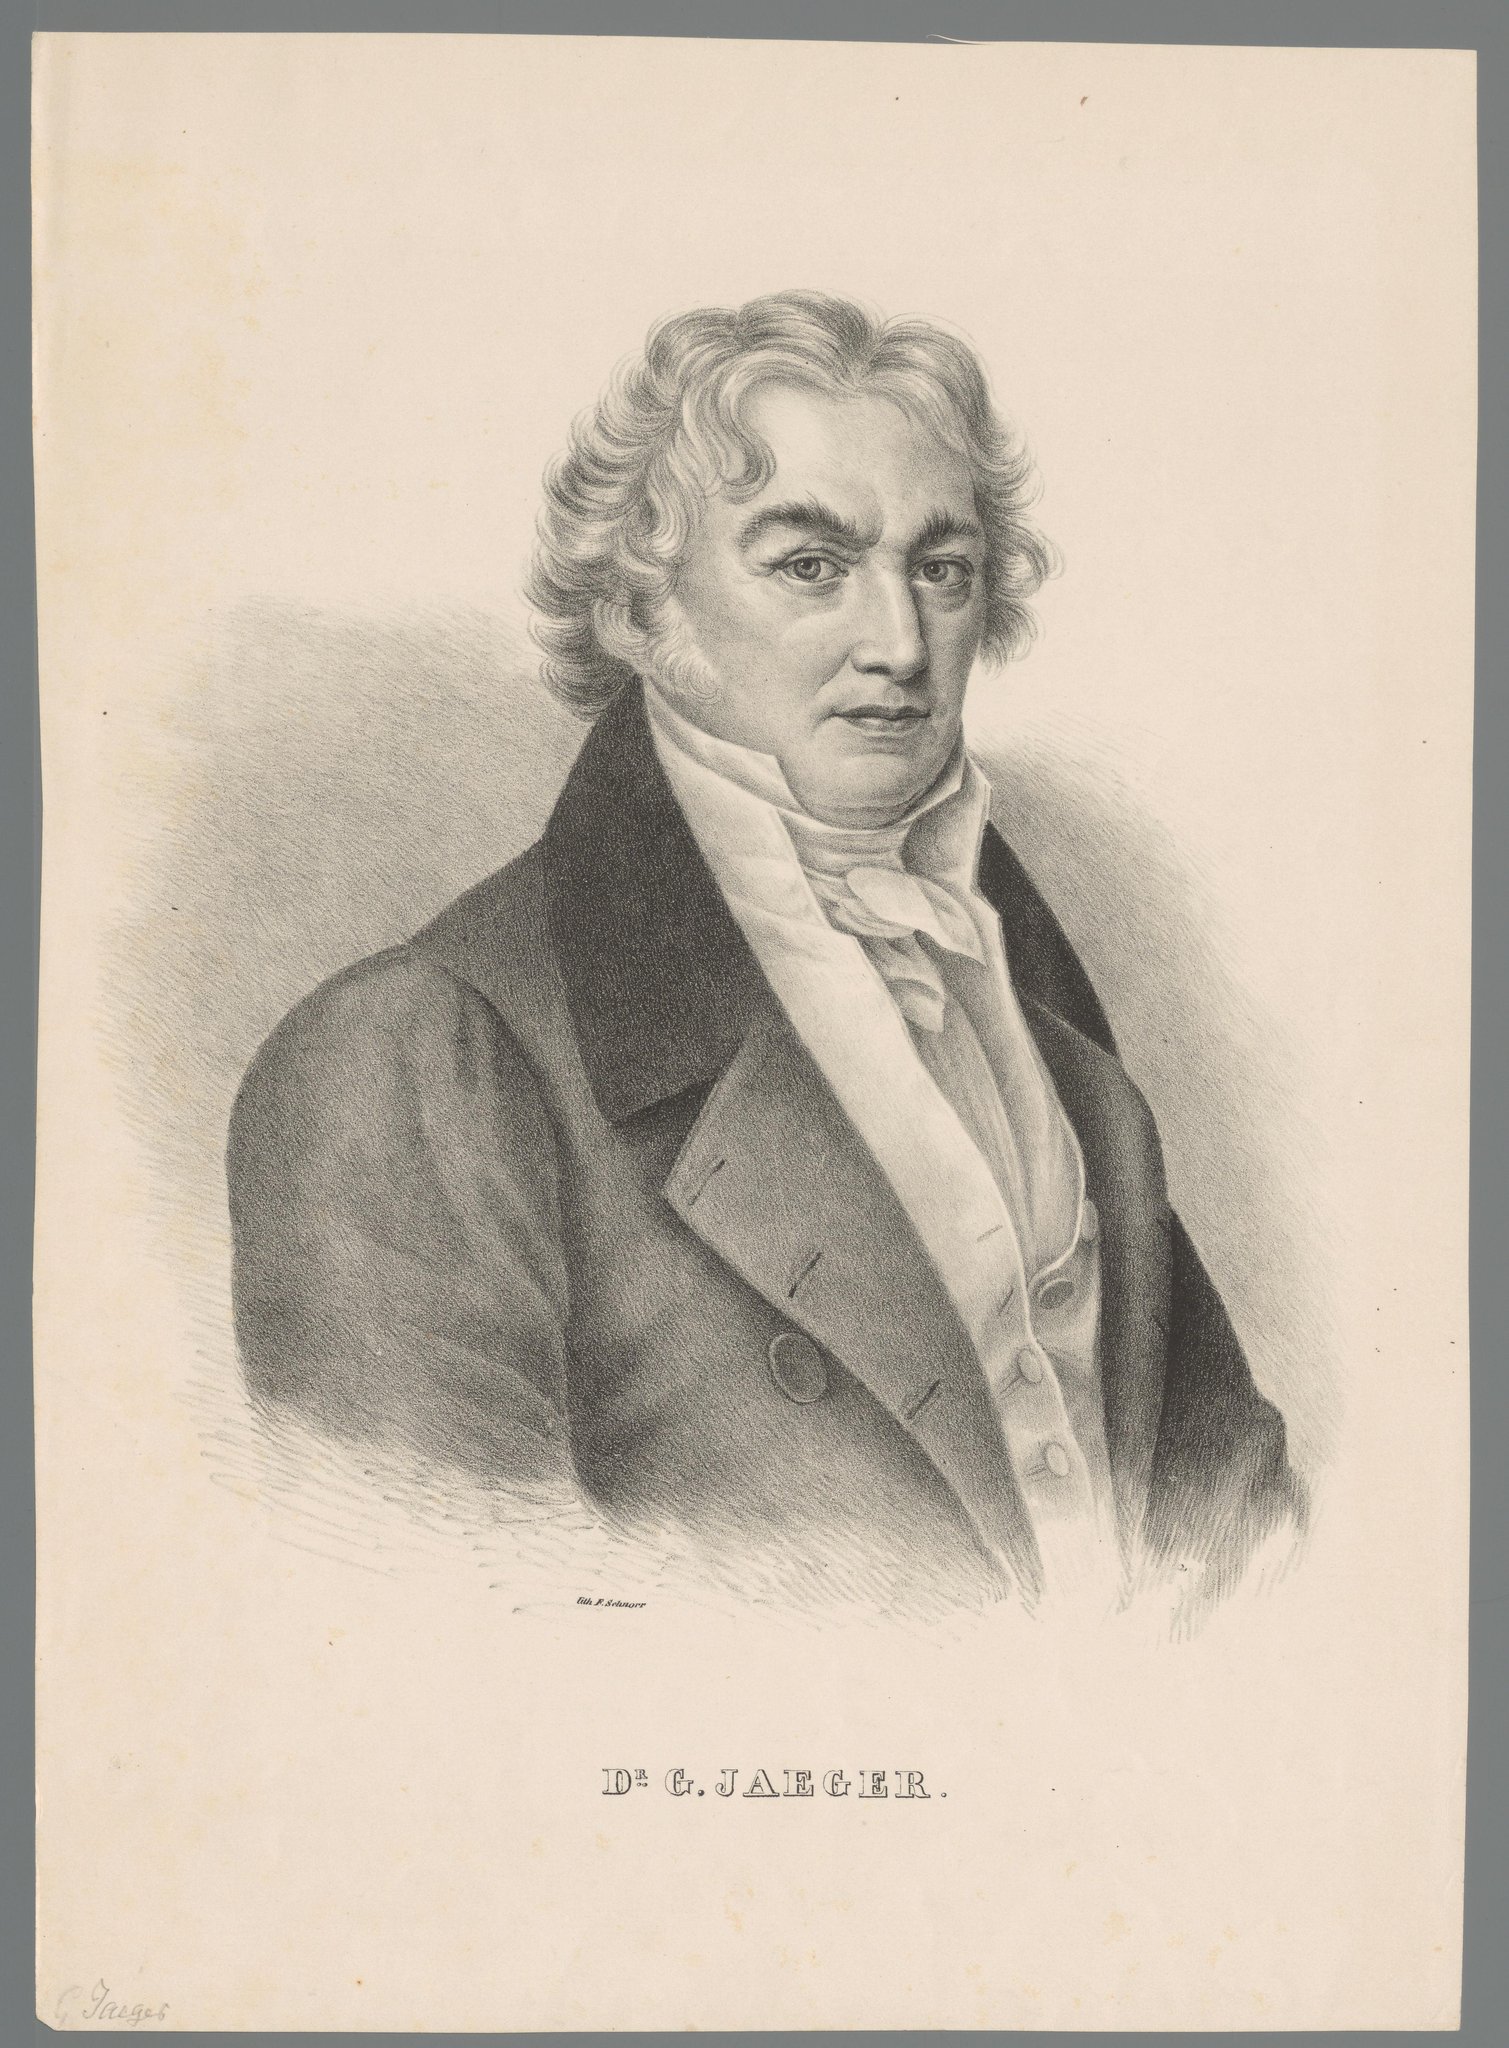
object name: print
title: Portret van G. Jaeger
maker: ludwig ferdinand schnorr von carolsfeld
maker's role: print maker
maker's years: 1788-1853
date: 1810-1853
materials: paper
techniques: lithograph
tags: historical persons not known by name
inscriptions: collector's mark: Lugt 2228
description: Portret van een verder onbekende man, met de naam G. Jaeger.